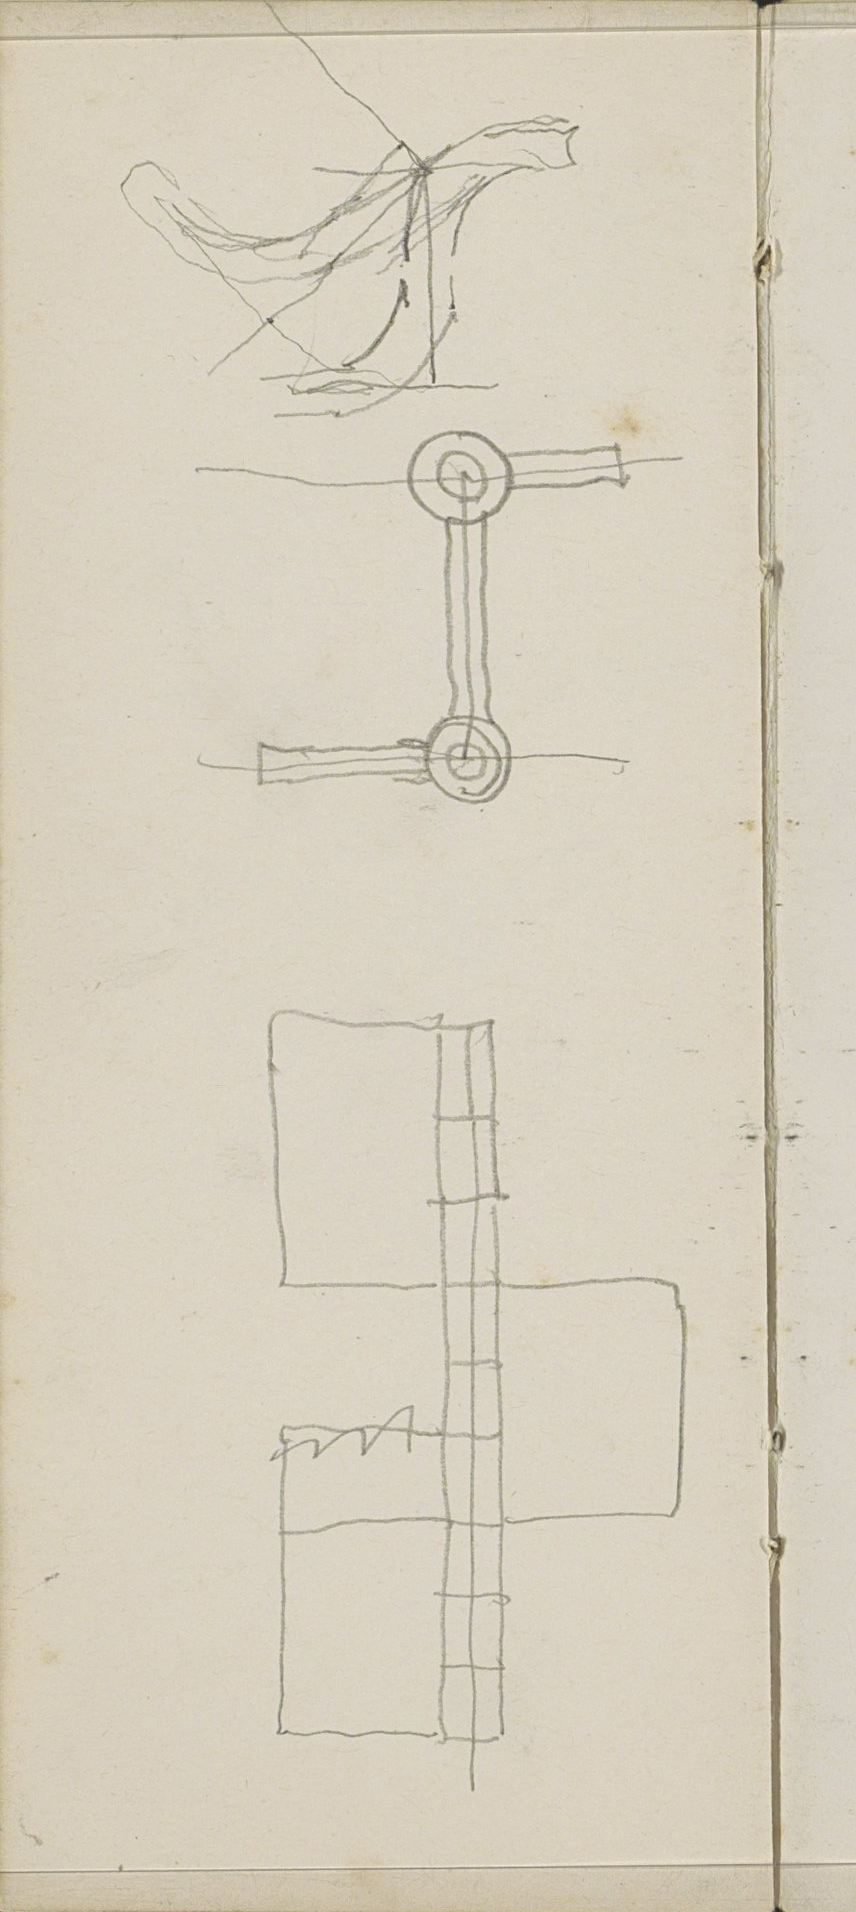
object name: sketchbook leaf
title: Studieblad, onder andere met een vogel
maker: gerrit willem dijsselhof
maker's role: designer, draughtsman, print maker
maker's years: 1866-1924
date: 1876-1924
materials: paper, pencil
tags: birds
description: Mogelijk ornamenten of (mechanische) constructies. Blad 12 verso uit een schetsboek met 40 bladen.